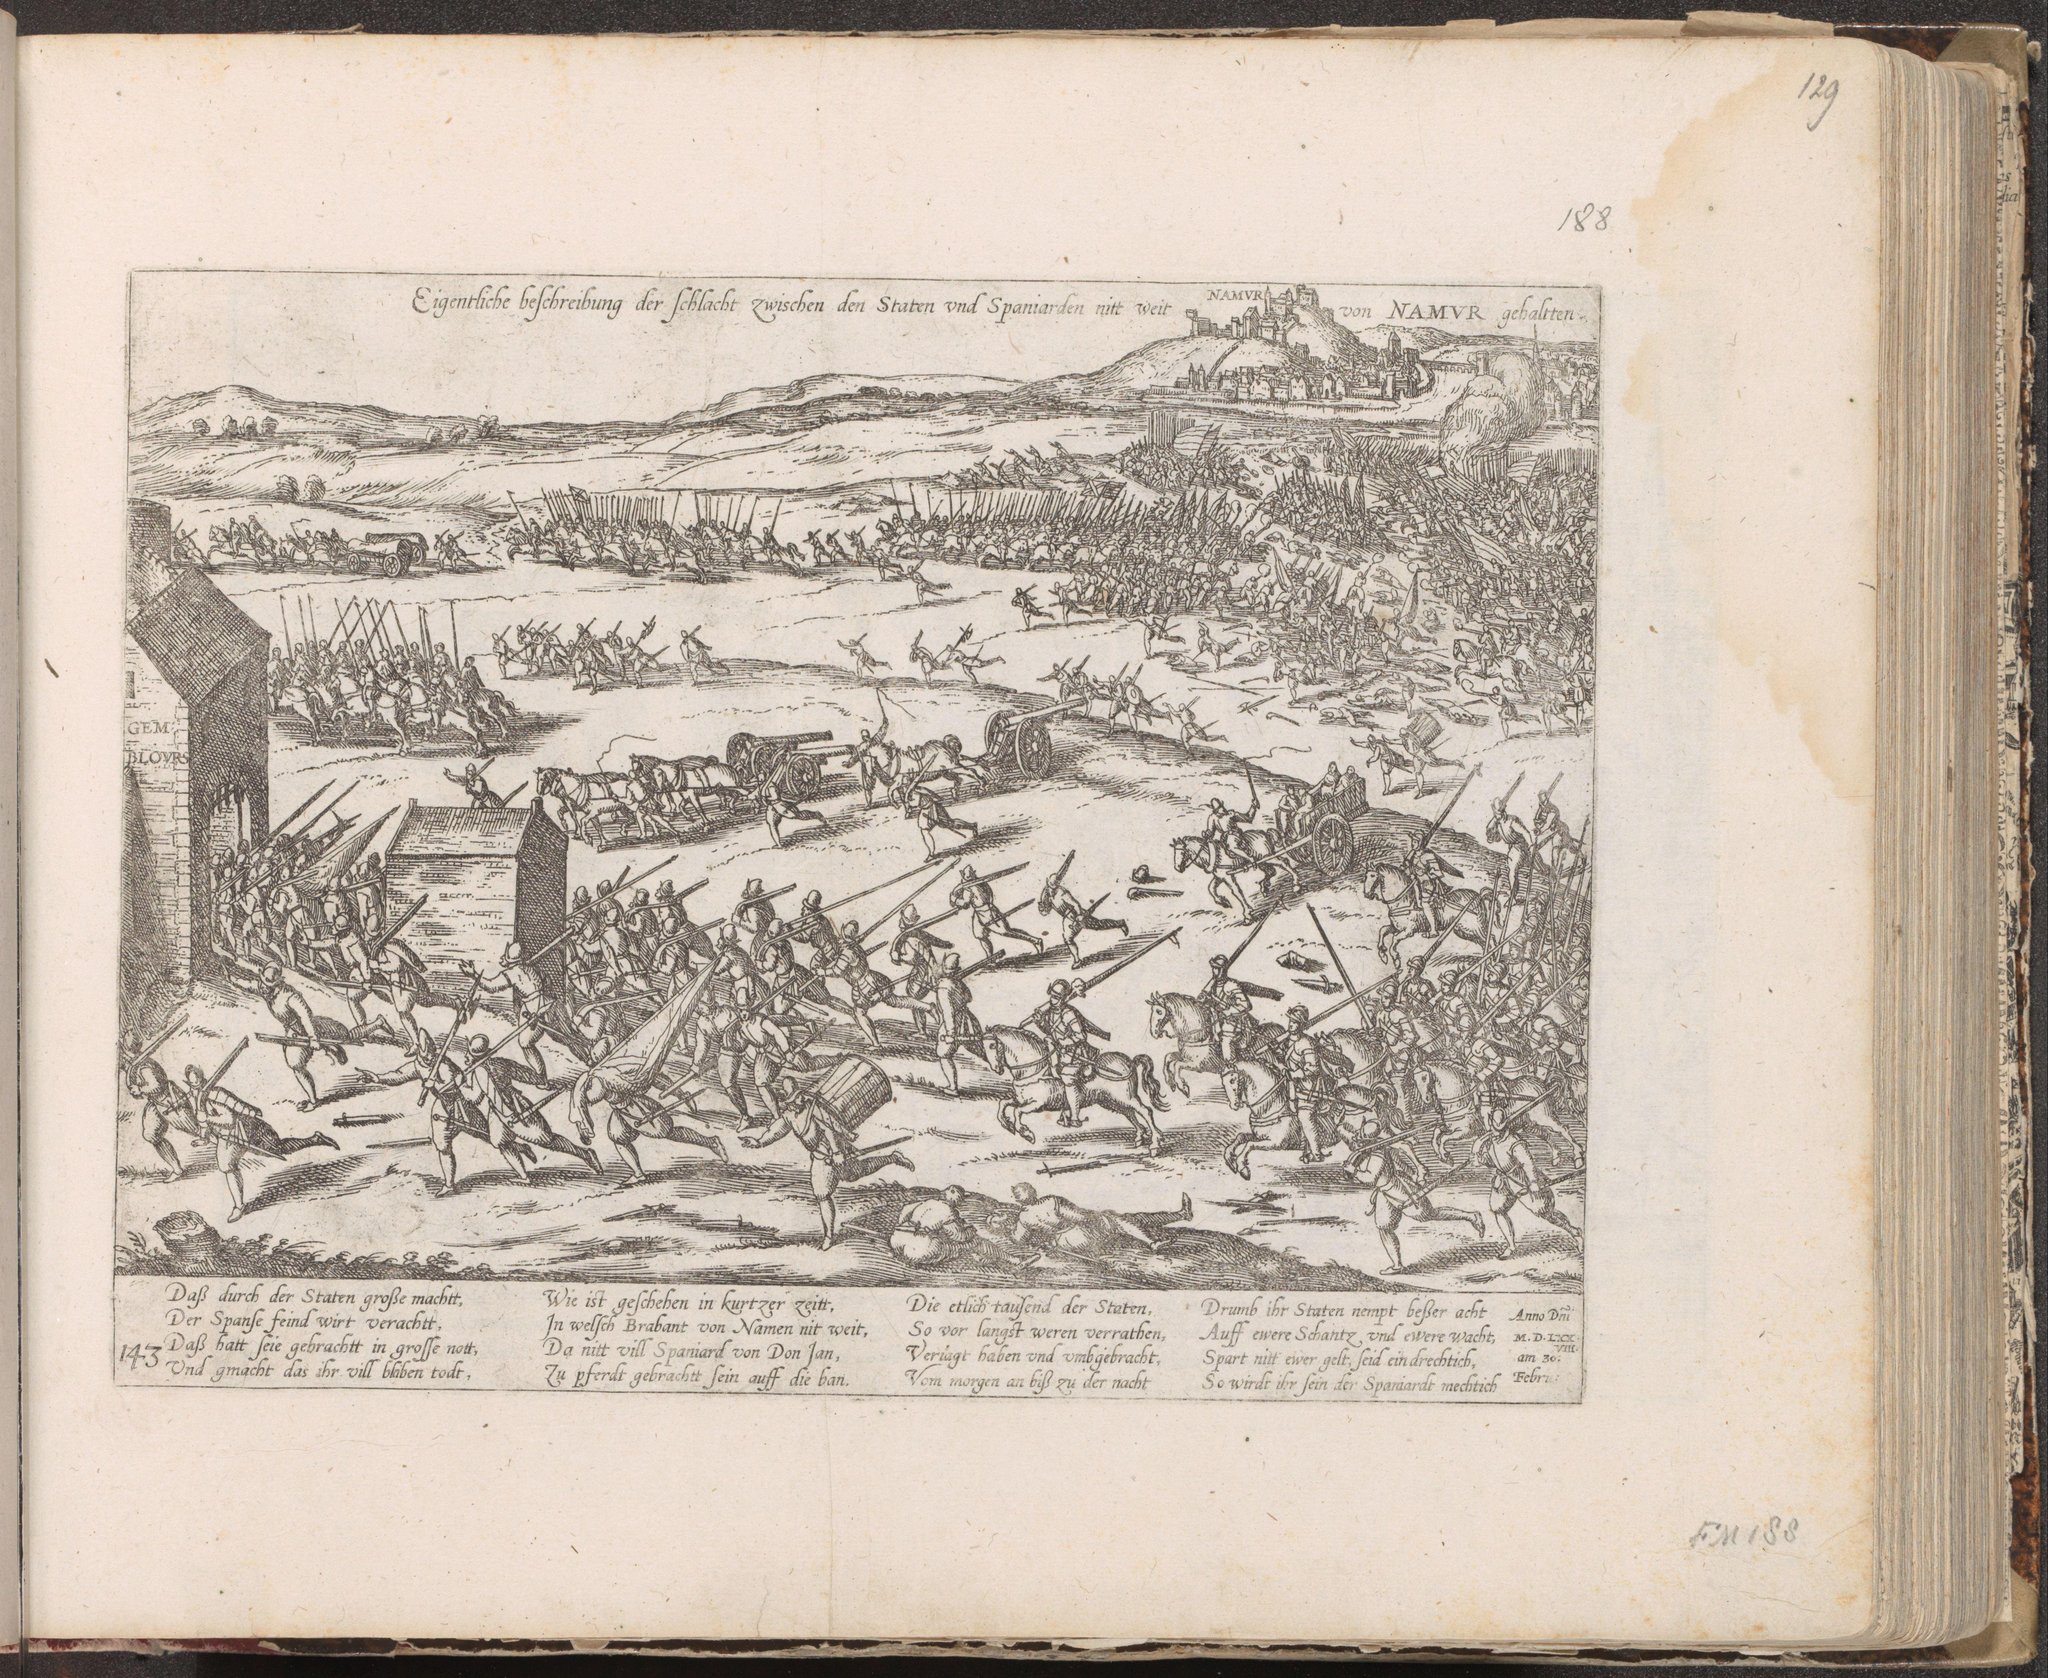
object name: history print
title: Slag bij Gembloers, 1578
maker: frans hogenberg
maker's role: print maker, publisher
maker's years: 1538-1590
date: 1581-1585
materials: paper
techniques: etching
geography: cologne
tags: battle (+ land forces)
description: Slag bij Gembloers, 31 januari 1578. Veldslag waarbij het Staatse leger verslagen wordt door het leger van Farnese. In de verte de stad Namen. Met onderschrift van 16 regels in het Duits. Linksonder genummerd: 143. De prent maakt deel uit van een album.